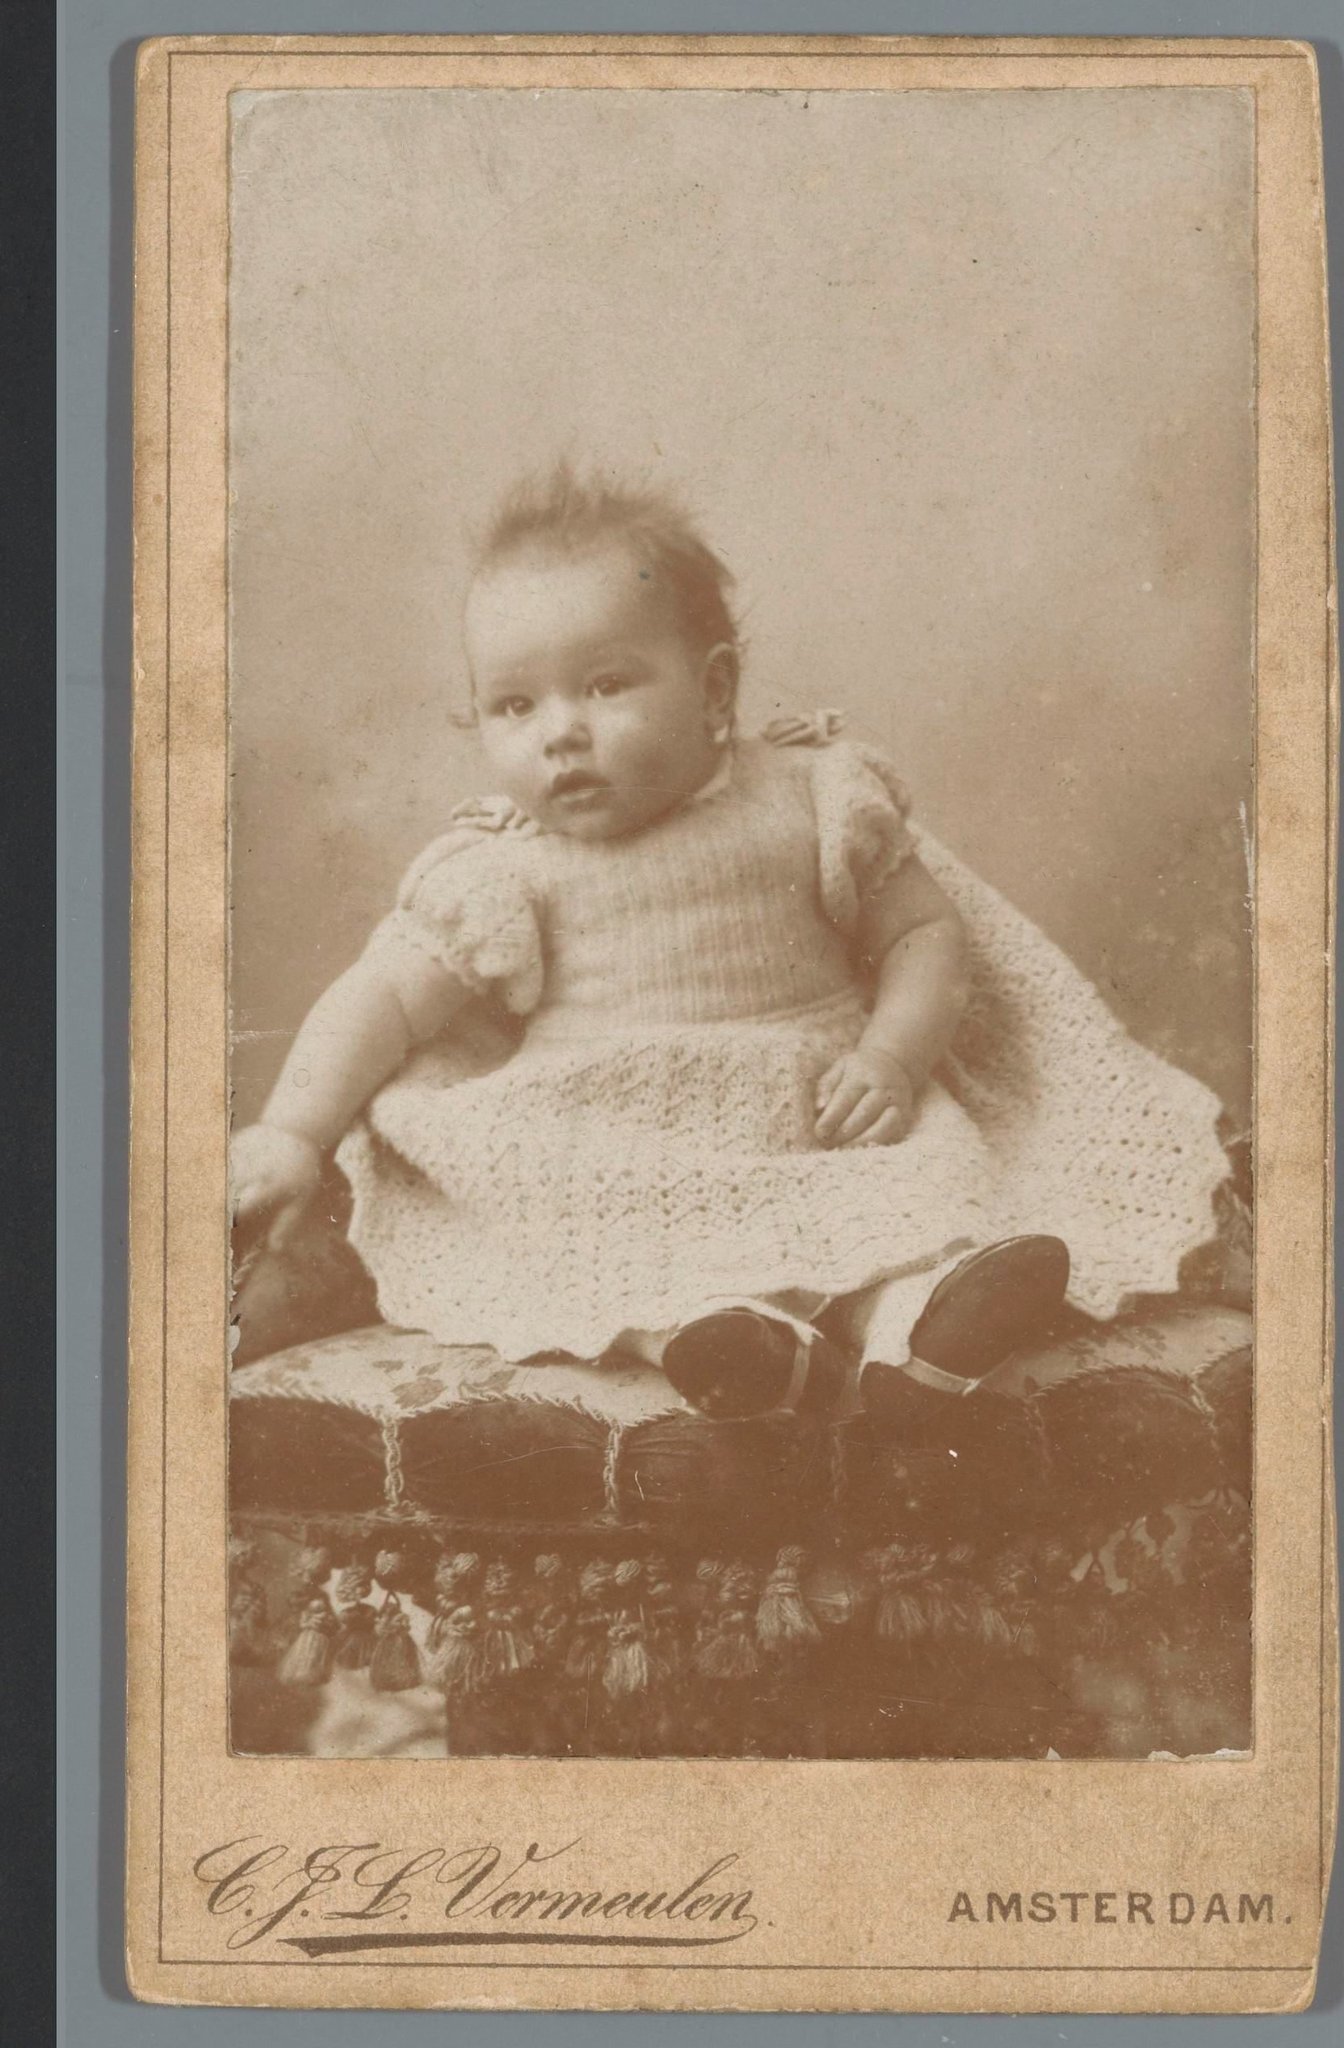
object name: photograph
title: Portret van een onbekende baby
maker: cornelis johannes lodewicus vermeulen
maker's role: fotograaf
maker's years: 1861-1936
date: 1888-1896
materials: cardboard, photographic support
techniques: collodion silver print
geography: amsterdam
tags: historical persons, infant, baby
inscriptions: inscription: ‘Photographische/ ATELIERS/ C. J. L. Vermeulen/ Heerenstraat 6,/ Heiligenweg/ hoek Singel/ AMSTERDAM./ Specialiteit in vergrootingen.’